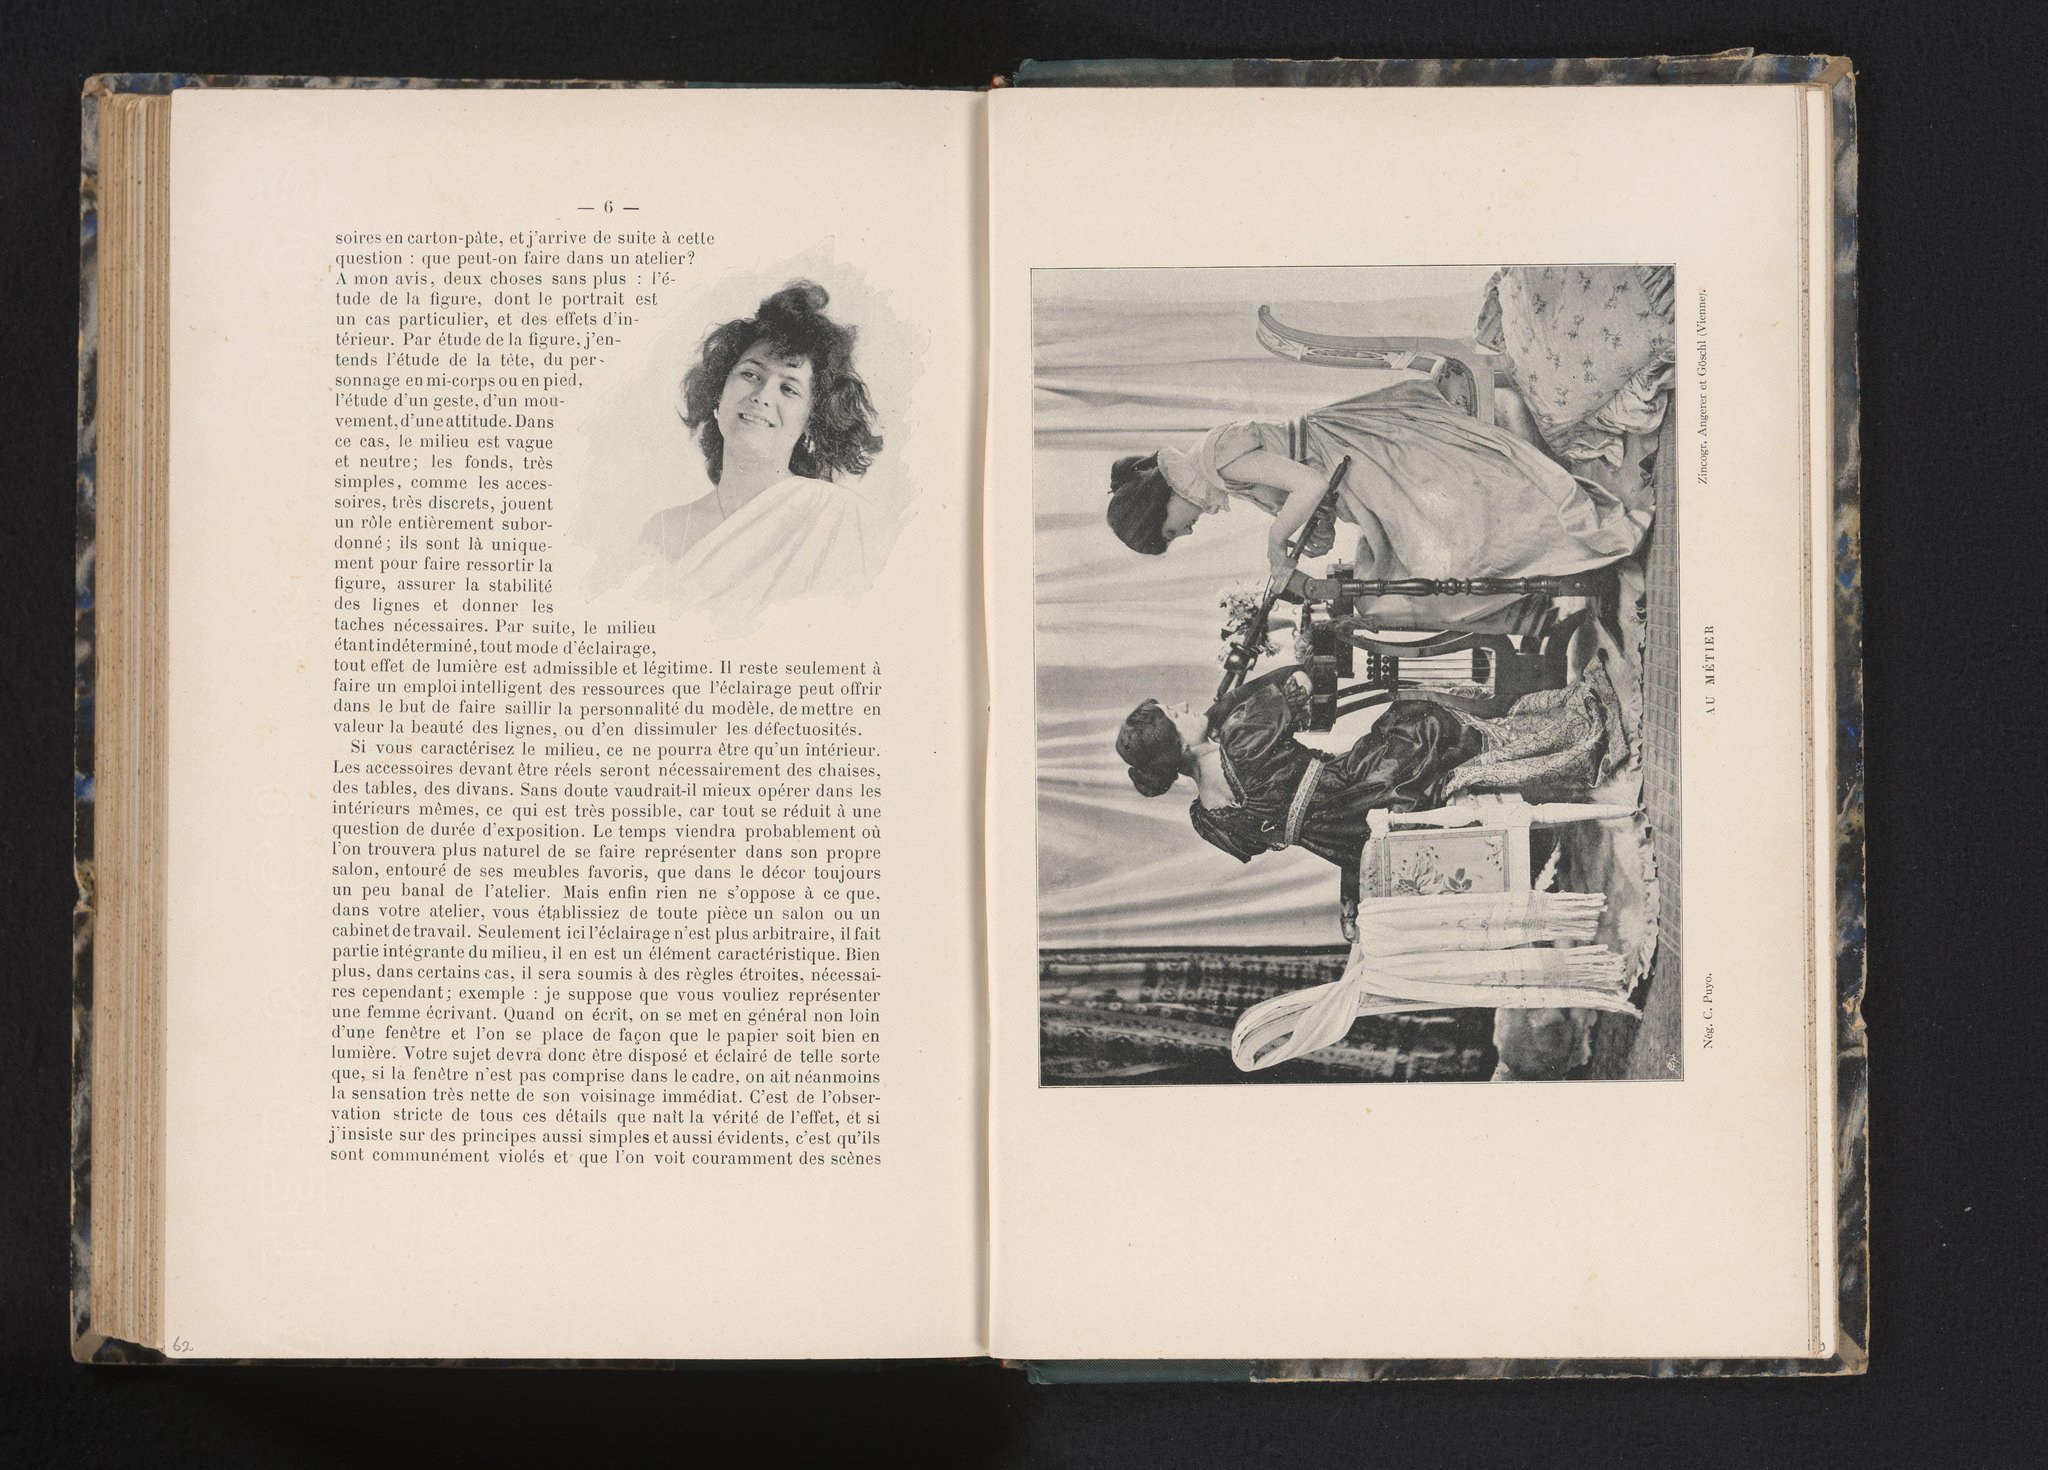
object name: photomechanical print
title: Au Métier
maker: constant puyo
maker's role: fotograaf, schrijver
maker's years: 1857-1933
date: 1891-1896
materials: paper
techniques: autotype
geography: vienna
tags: manufacturing with yarn (+ women (labourers))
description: Prent tegenover pagina 6 van het supplement Note sur l'Art photographique achterin het boek.